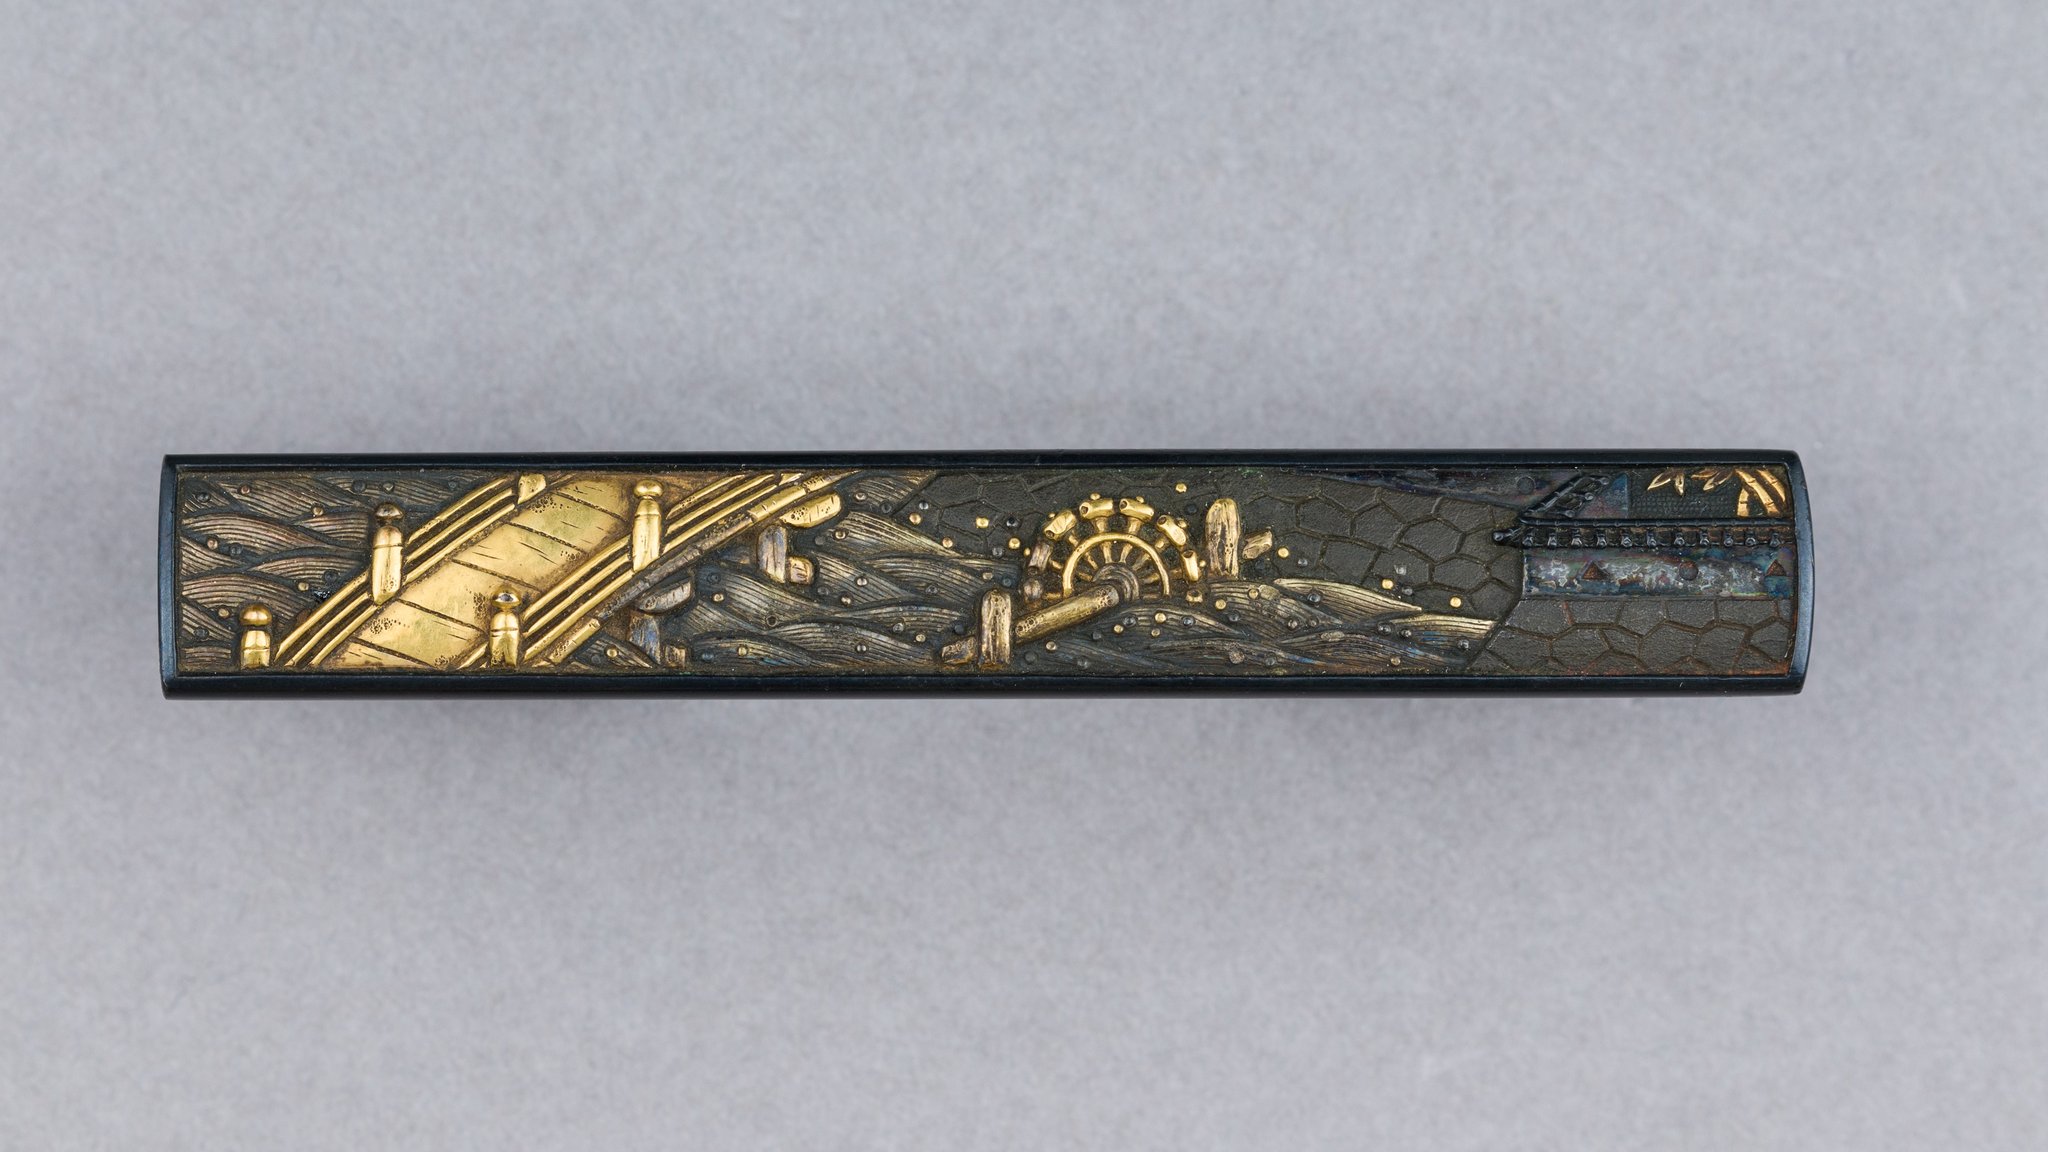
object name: knife handle kozuka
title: Knife Handle (Kozuka)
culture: japanese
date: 1601-1700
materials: brass, gold alloy, silver alloy, gold, iron, silver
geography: japan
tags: bridges